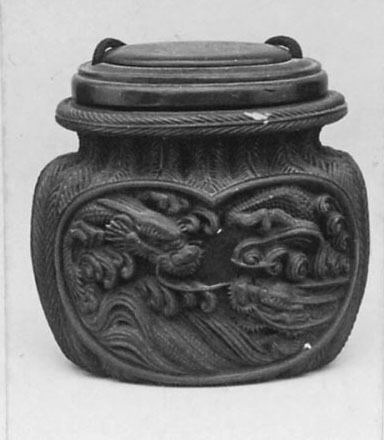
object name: jar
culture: japanese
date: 1801-1900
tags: dragons